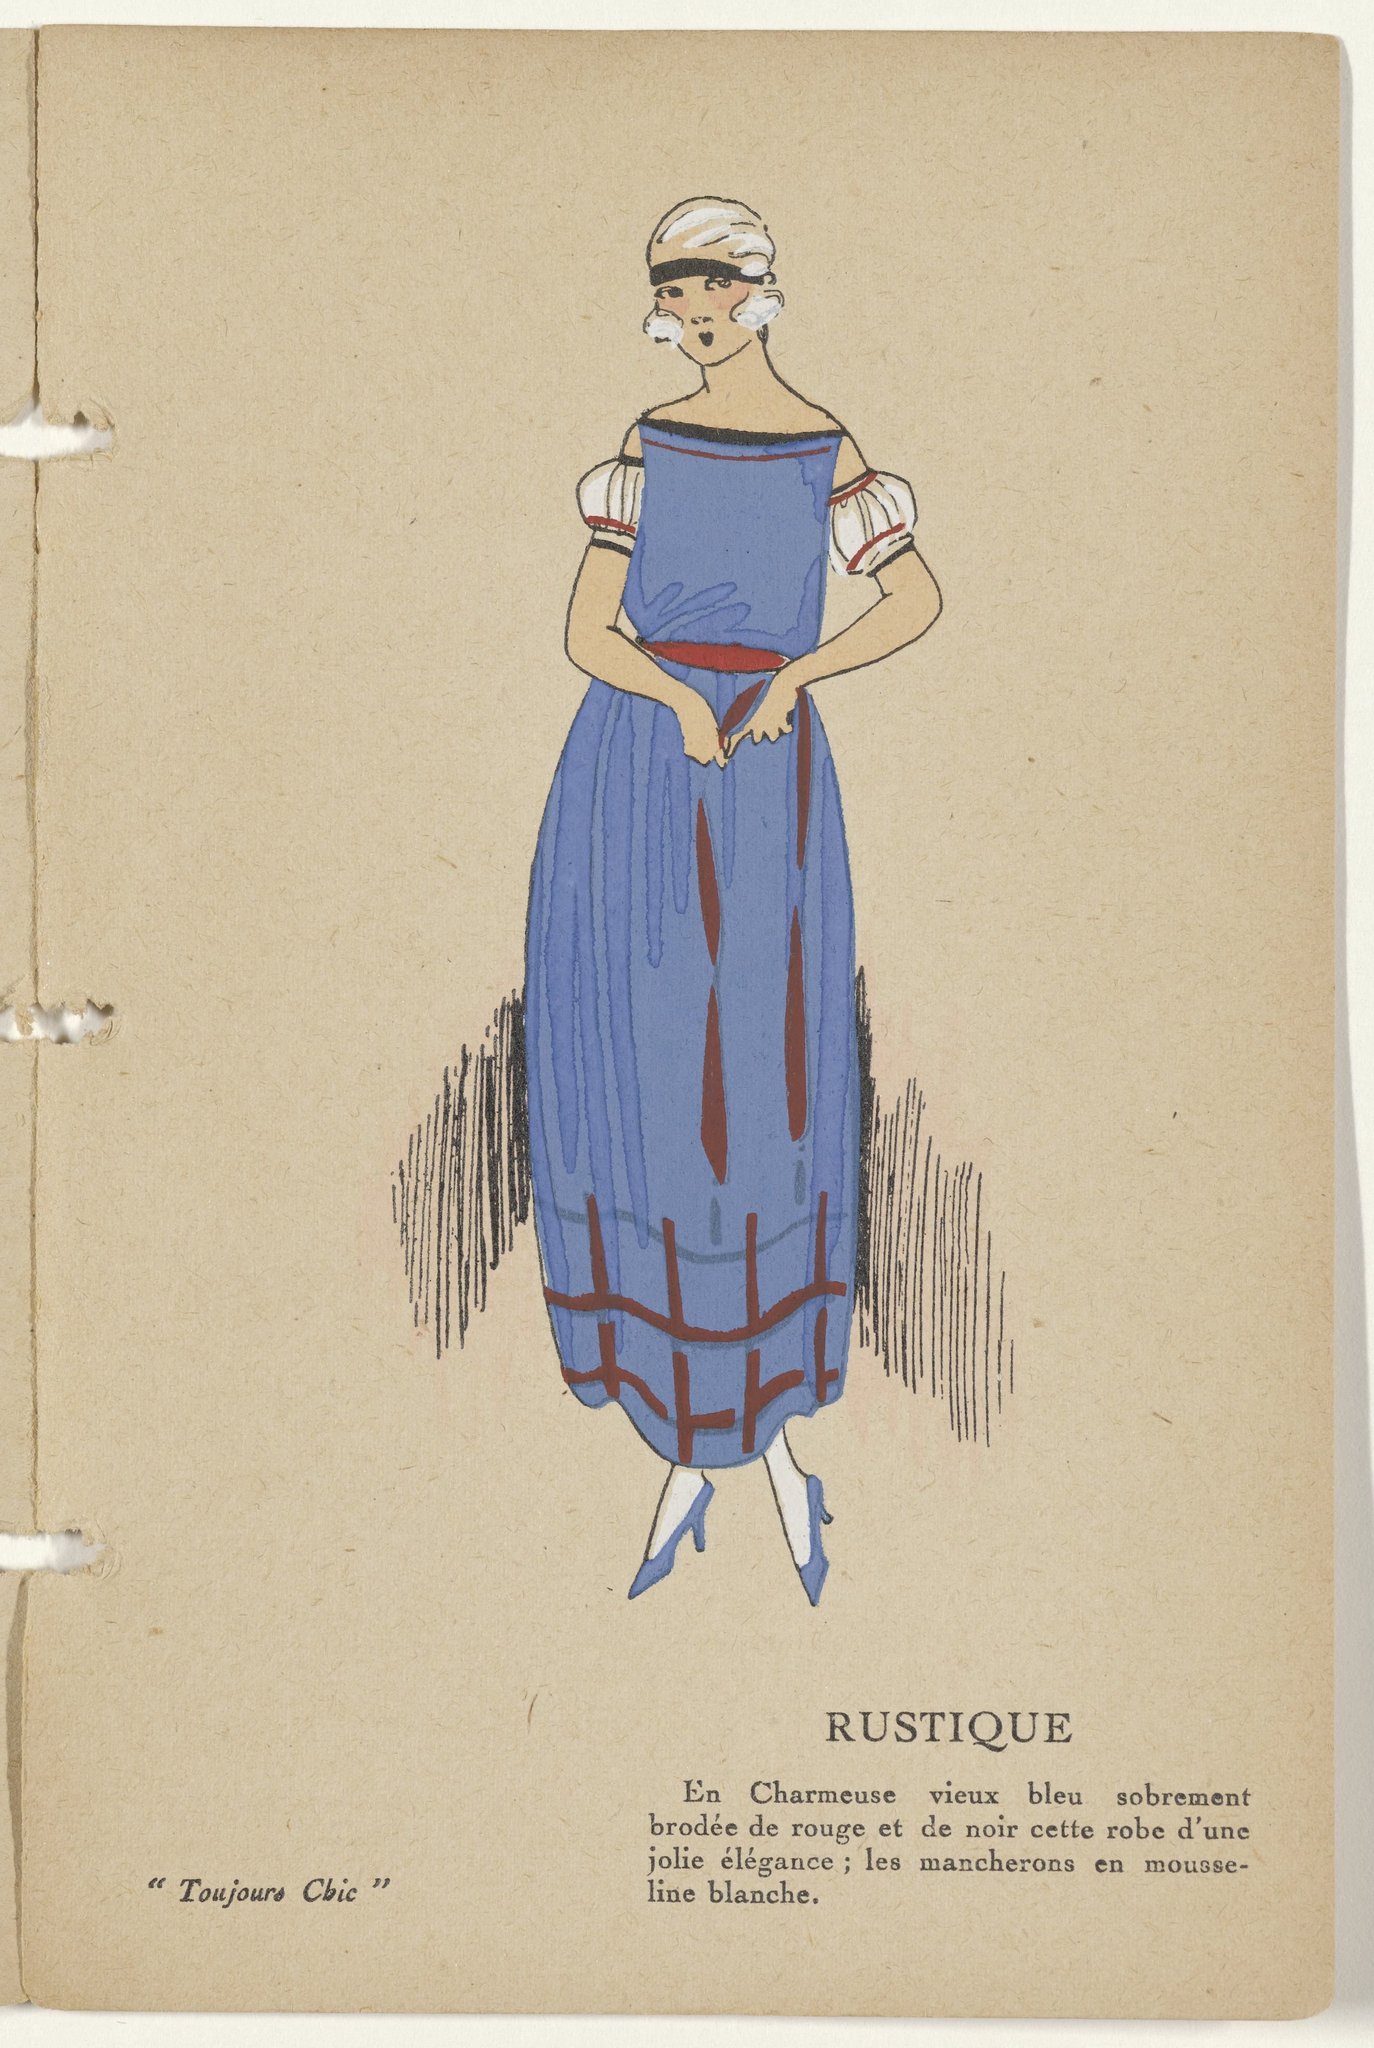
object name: fashion print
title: Toujours Chic Les Robes, Hiver 1921-1922: Rustique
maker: g-p. joumard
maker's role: publisher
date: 1921-1922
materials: paper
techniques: letterpress printing, pochoir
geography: paris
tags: fashion plates, dress, gown (+ women's clothes)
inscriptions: date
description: Prent uit Catalogus "Toujours Chic" waarin een overzicht van de wintermode 1921-1922 in 80 prentjes in pochoir techniek.